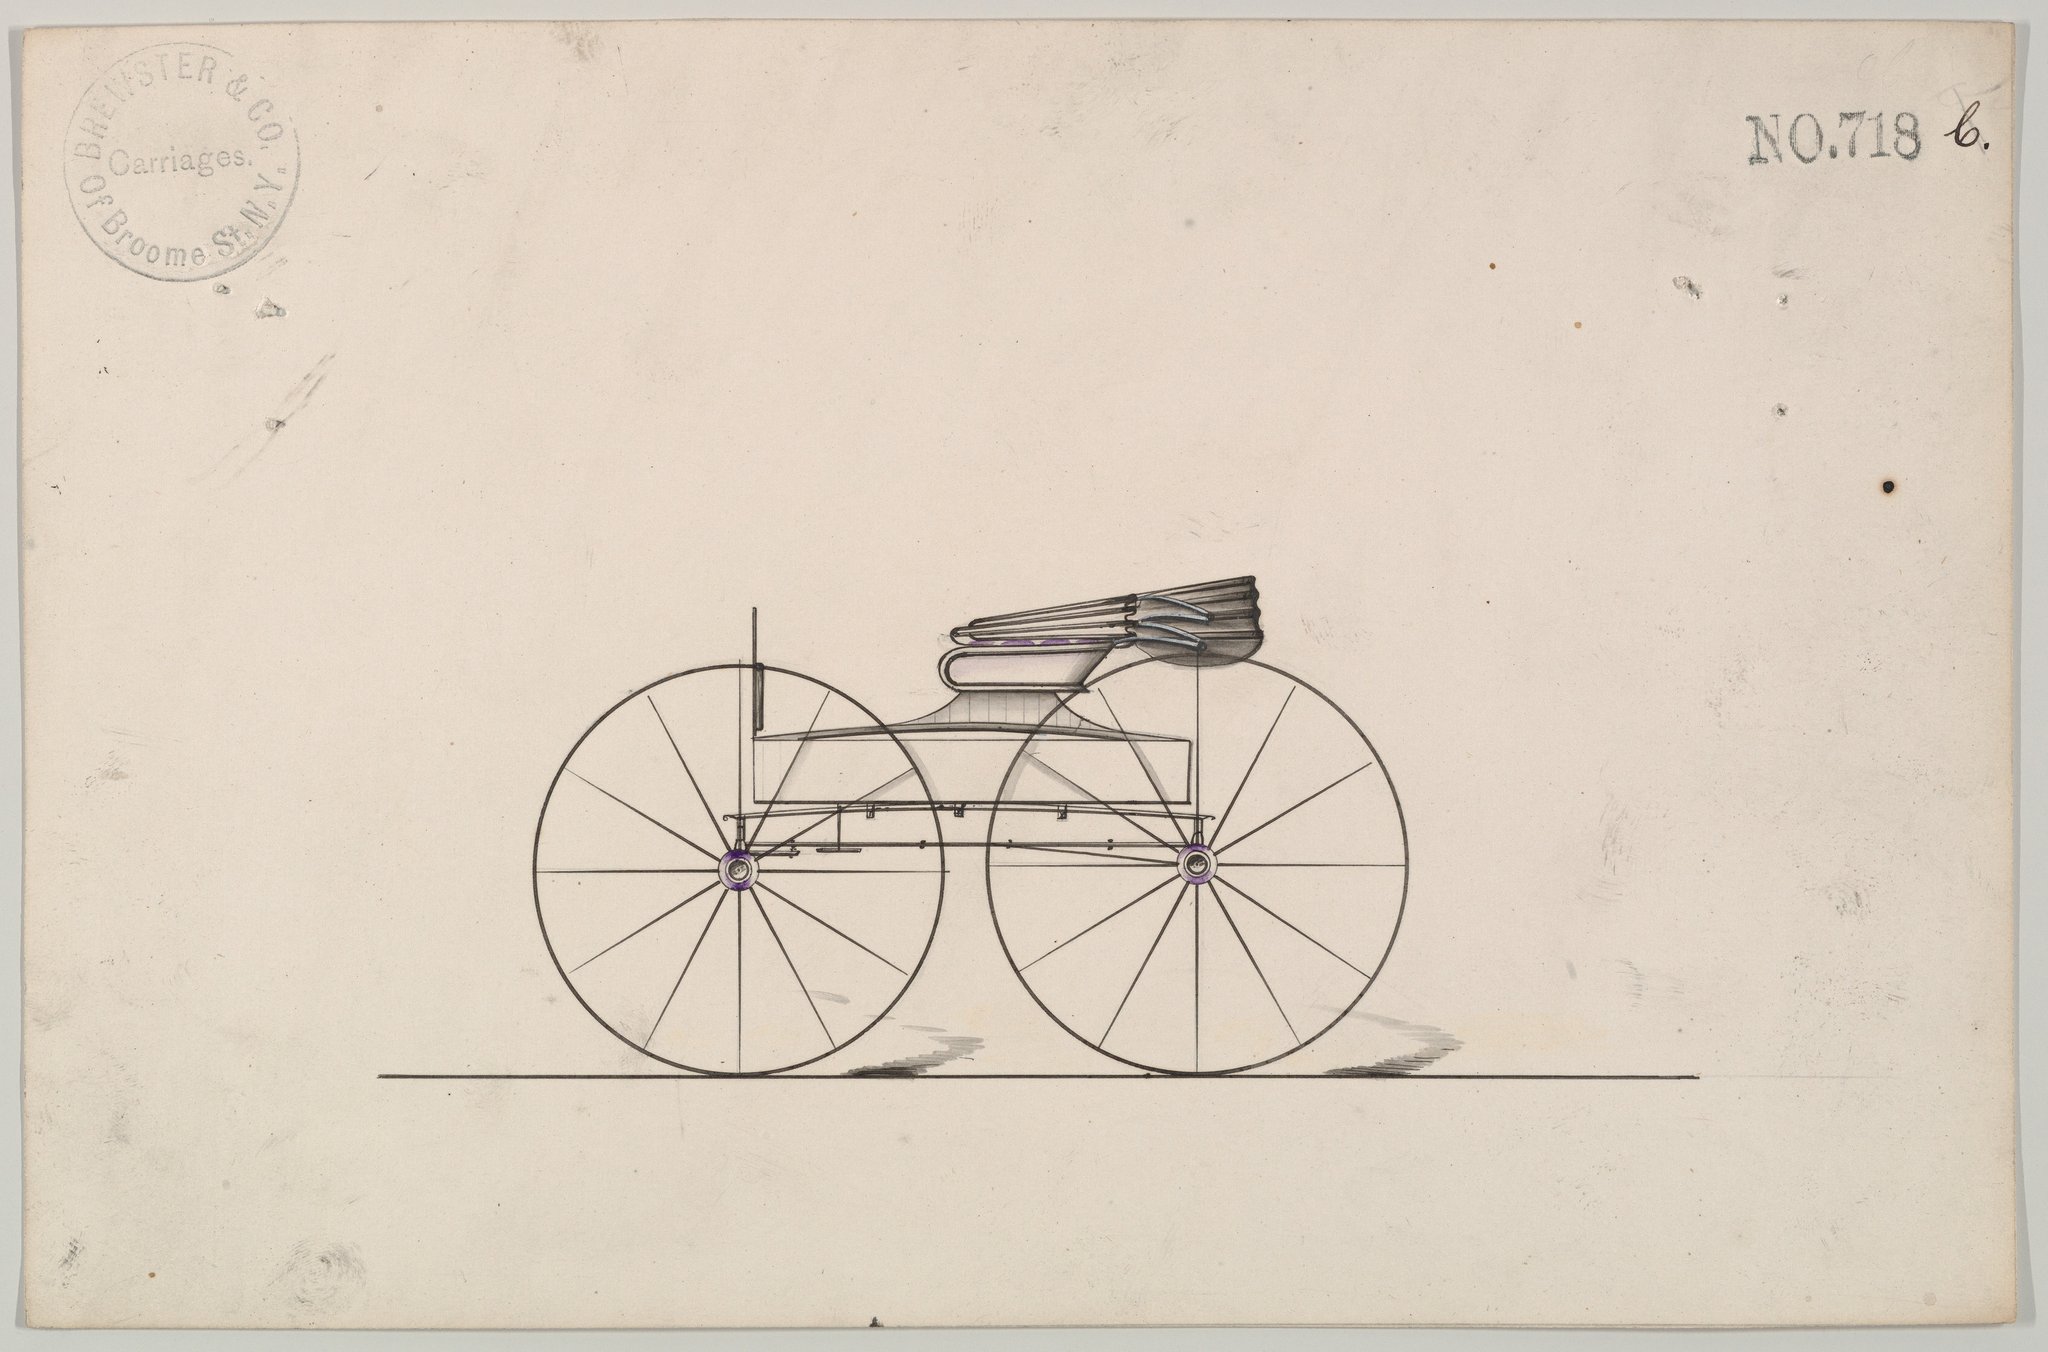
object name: drawing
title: Design for Wagon, no. 718c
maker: brewster & co.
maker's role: manufacturer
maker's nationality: american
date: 1860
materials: gouache, ink, watercolor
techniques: pen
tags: carriages